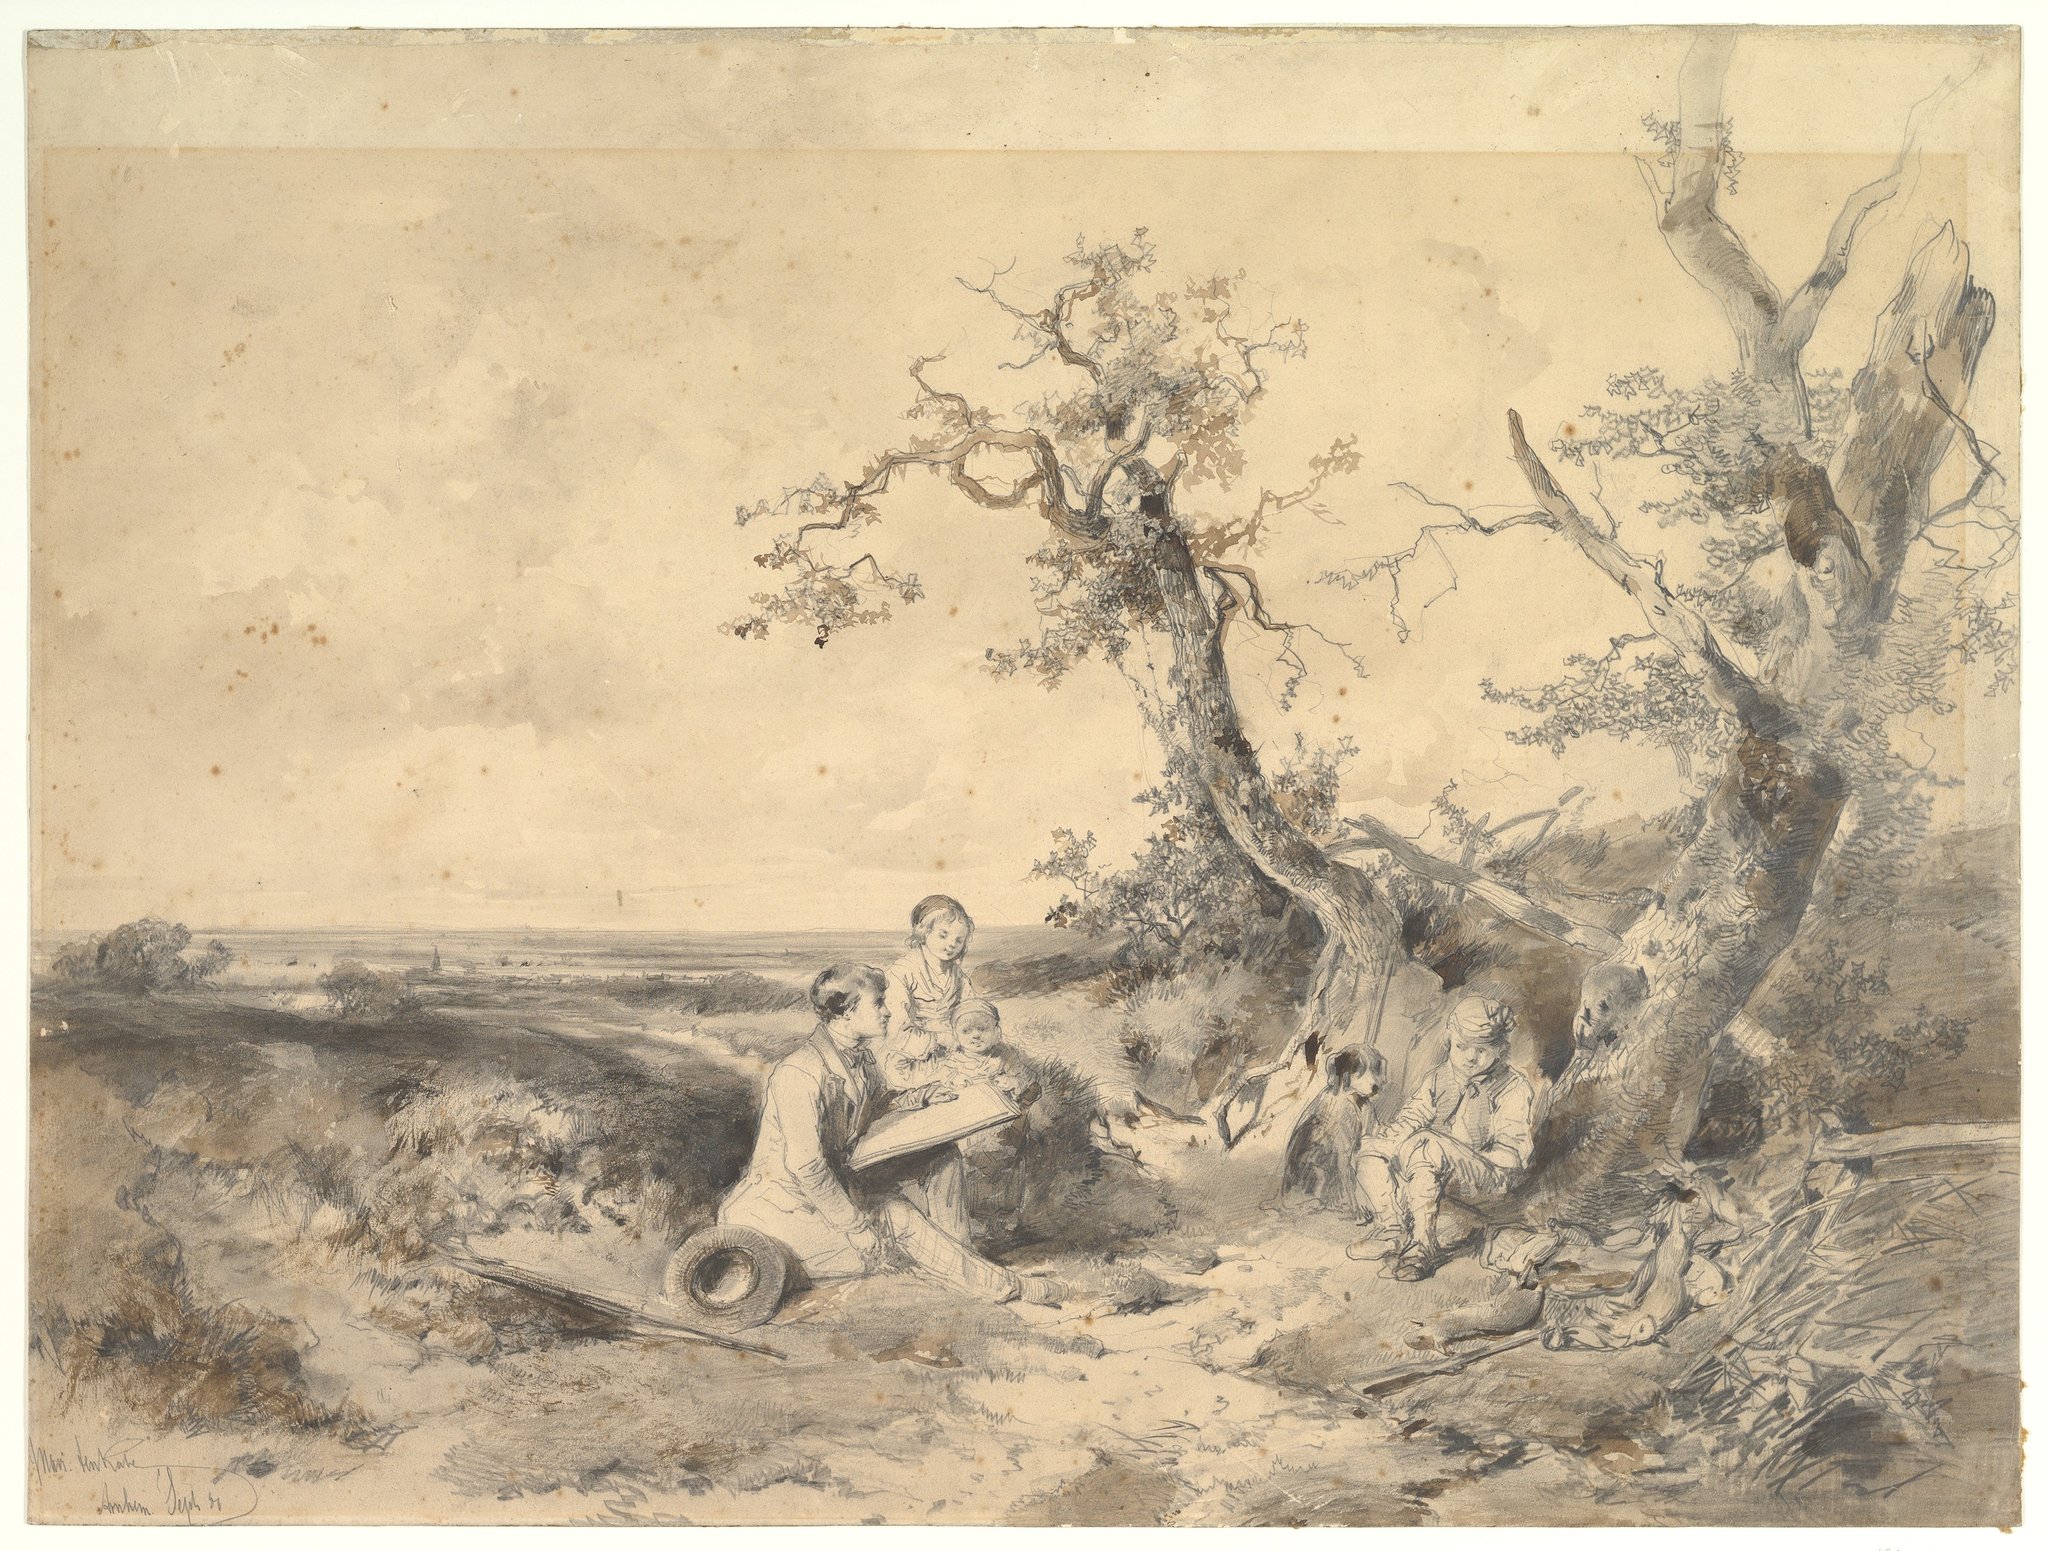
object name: drawing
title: Landscape with an Artist Sketching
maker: mari ten kate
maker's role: artist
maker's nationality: dutch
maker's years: 1831-1910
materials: graphite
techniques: wash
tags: painting,men,women,landscapes,trees